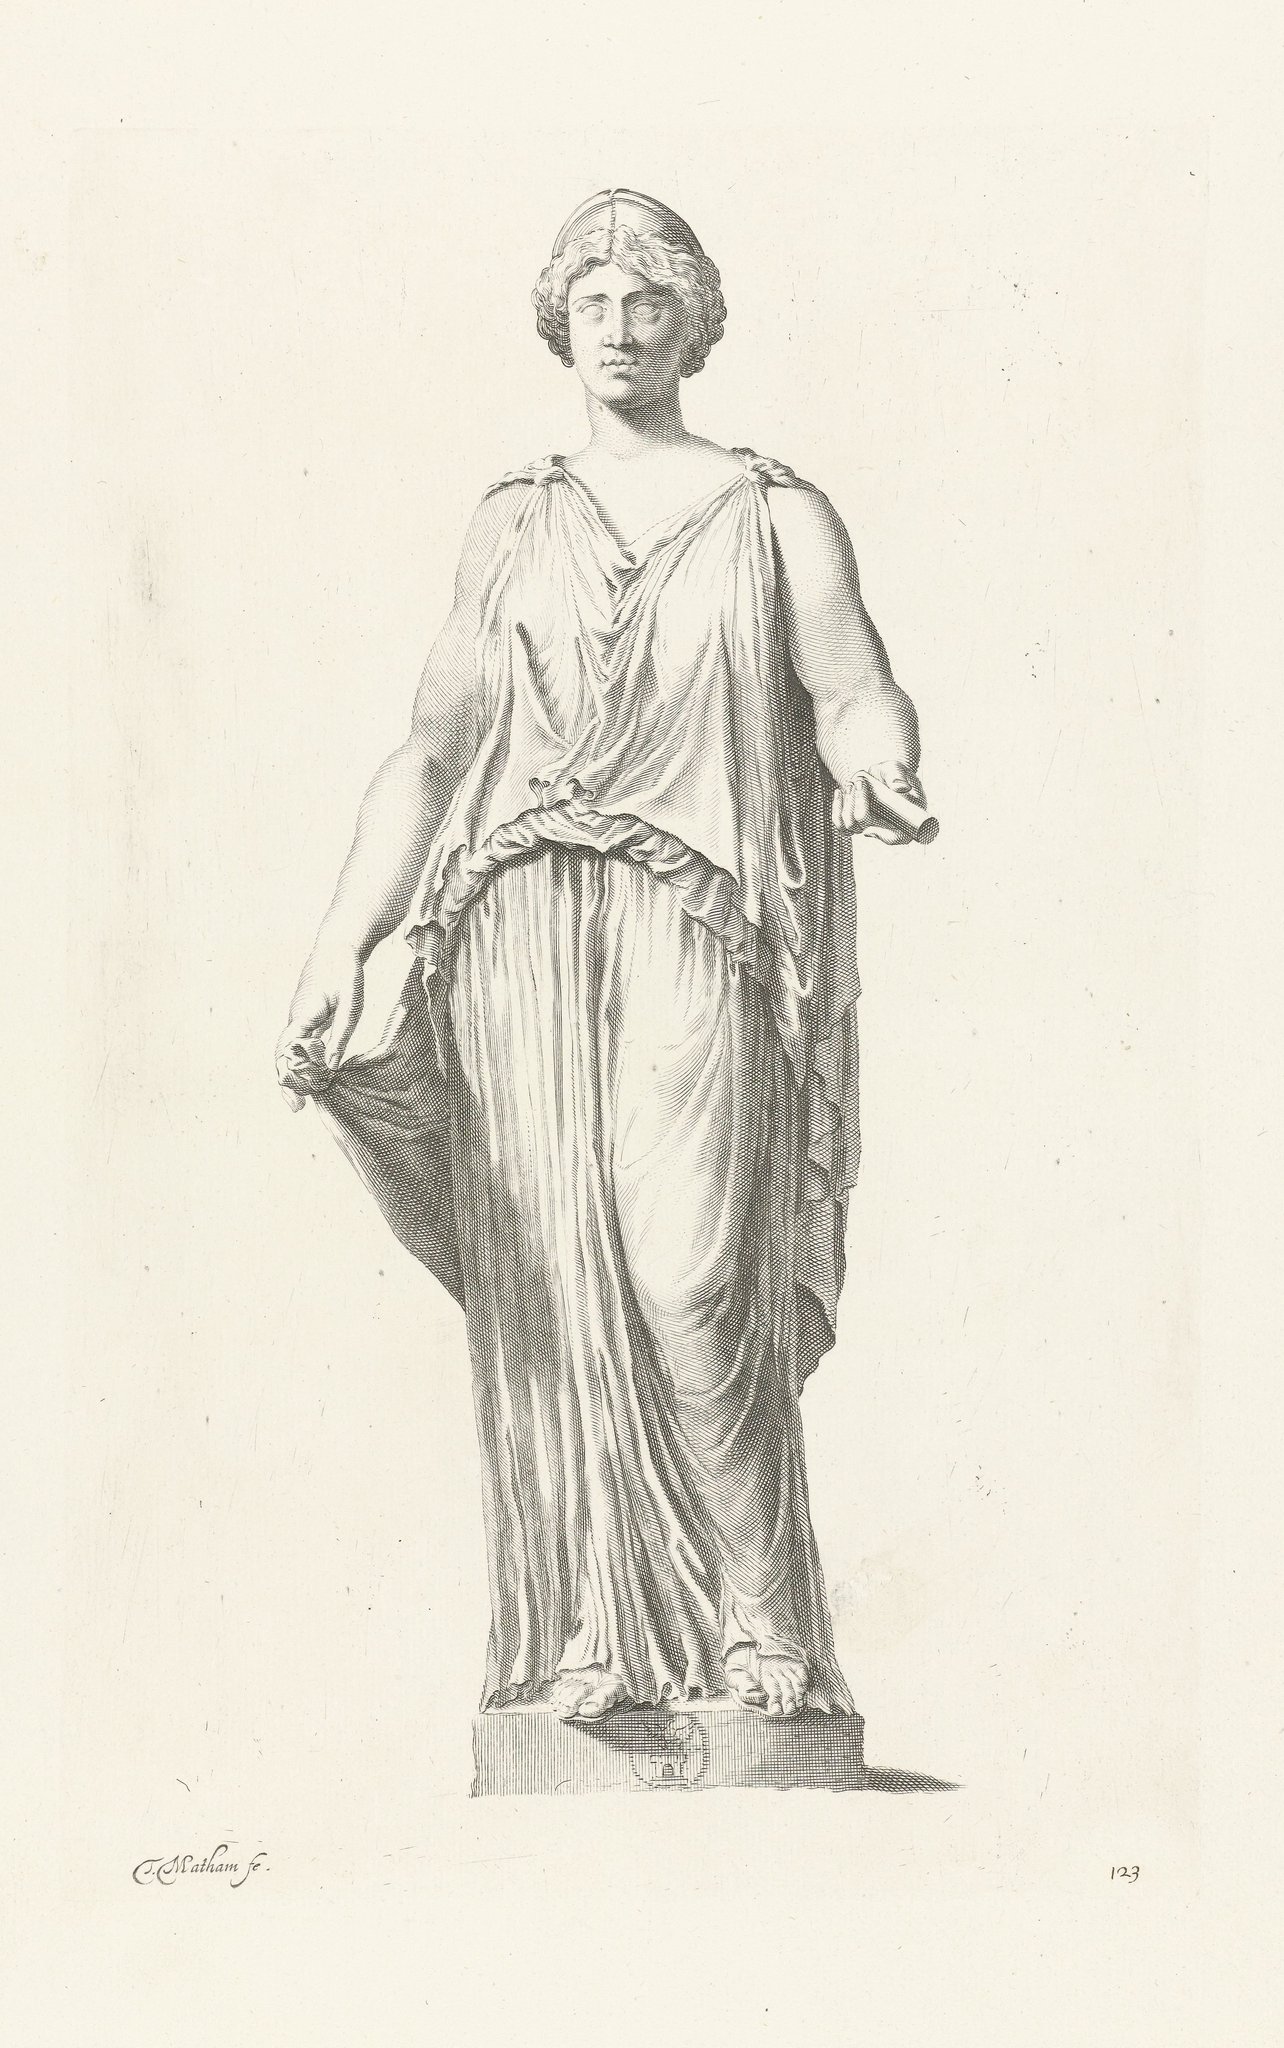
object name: print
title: Galleria Giustiniana del Marchese Vincenzo Giustiniani I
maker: theodor matham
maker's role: draughtsman, print maker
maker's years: 1605-1676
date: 1640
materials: paper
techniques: engraving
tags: rome, vincenzo giustiniani (1564-1637), piece of sculpture, reproduction of a piece of sculpture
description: Standbeeld van een vrouw. Onderaan het wapenschild van Vincenzo Giustiniani. Prent uit een publicatie met reproductieprenten naar de sculpturen in de verzameling in de Galleria Giustiniani te Rome.